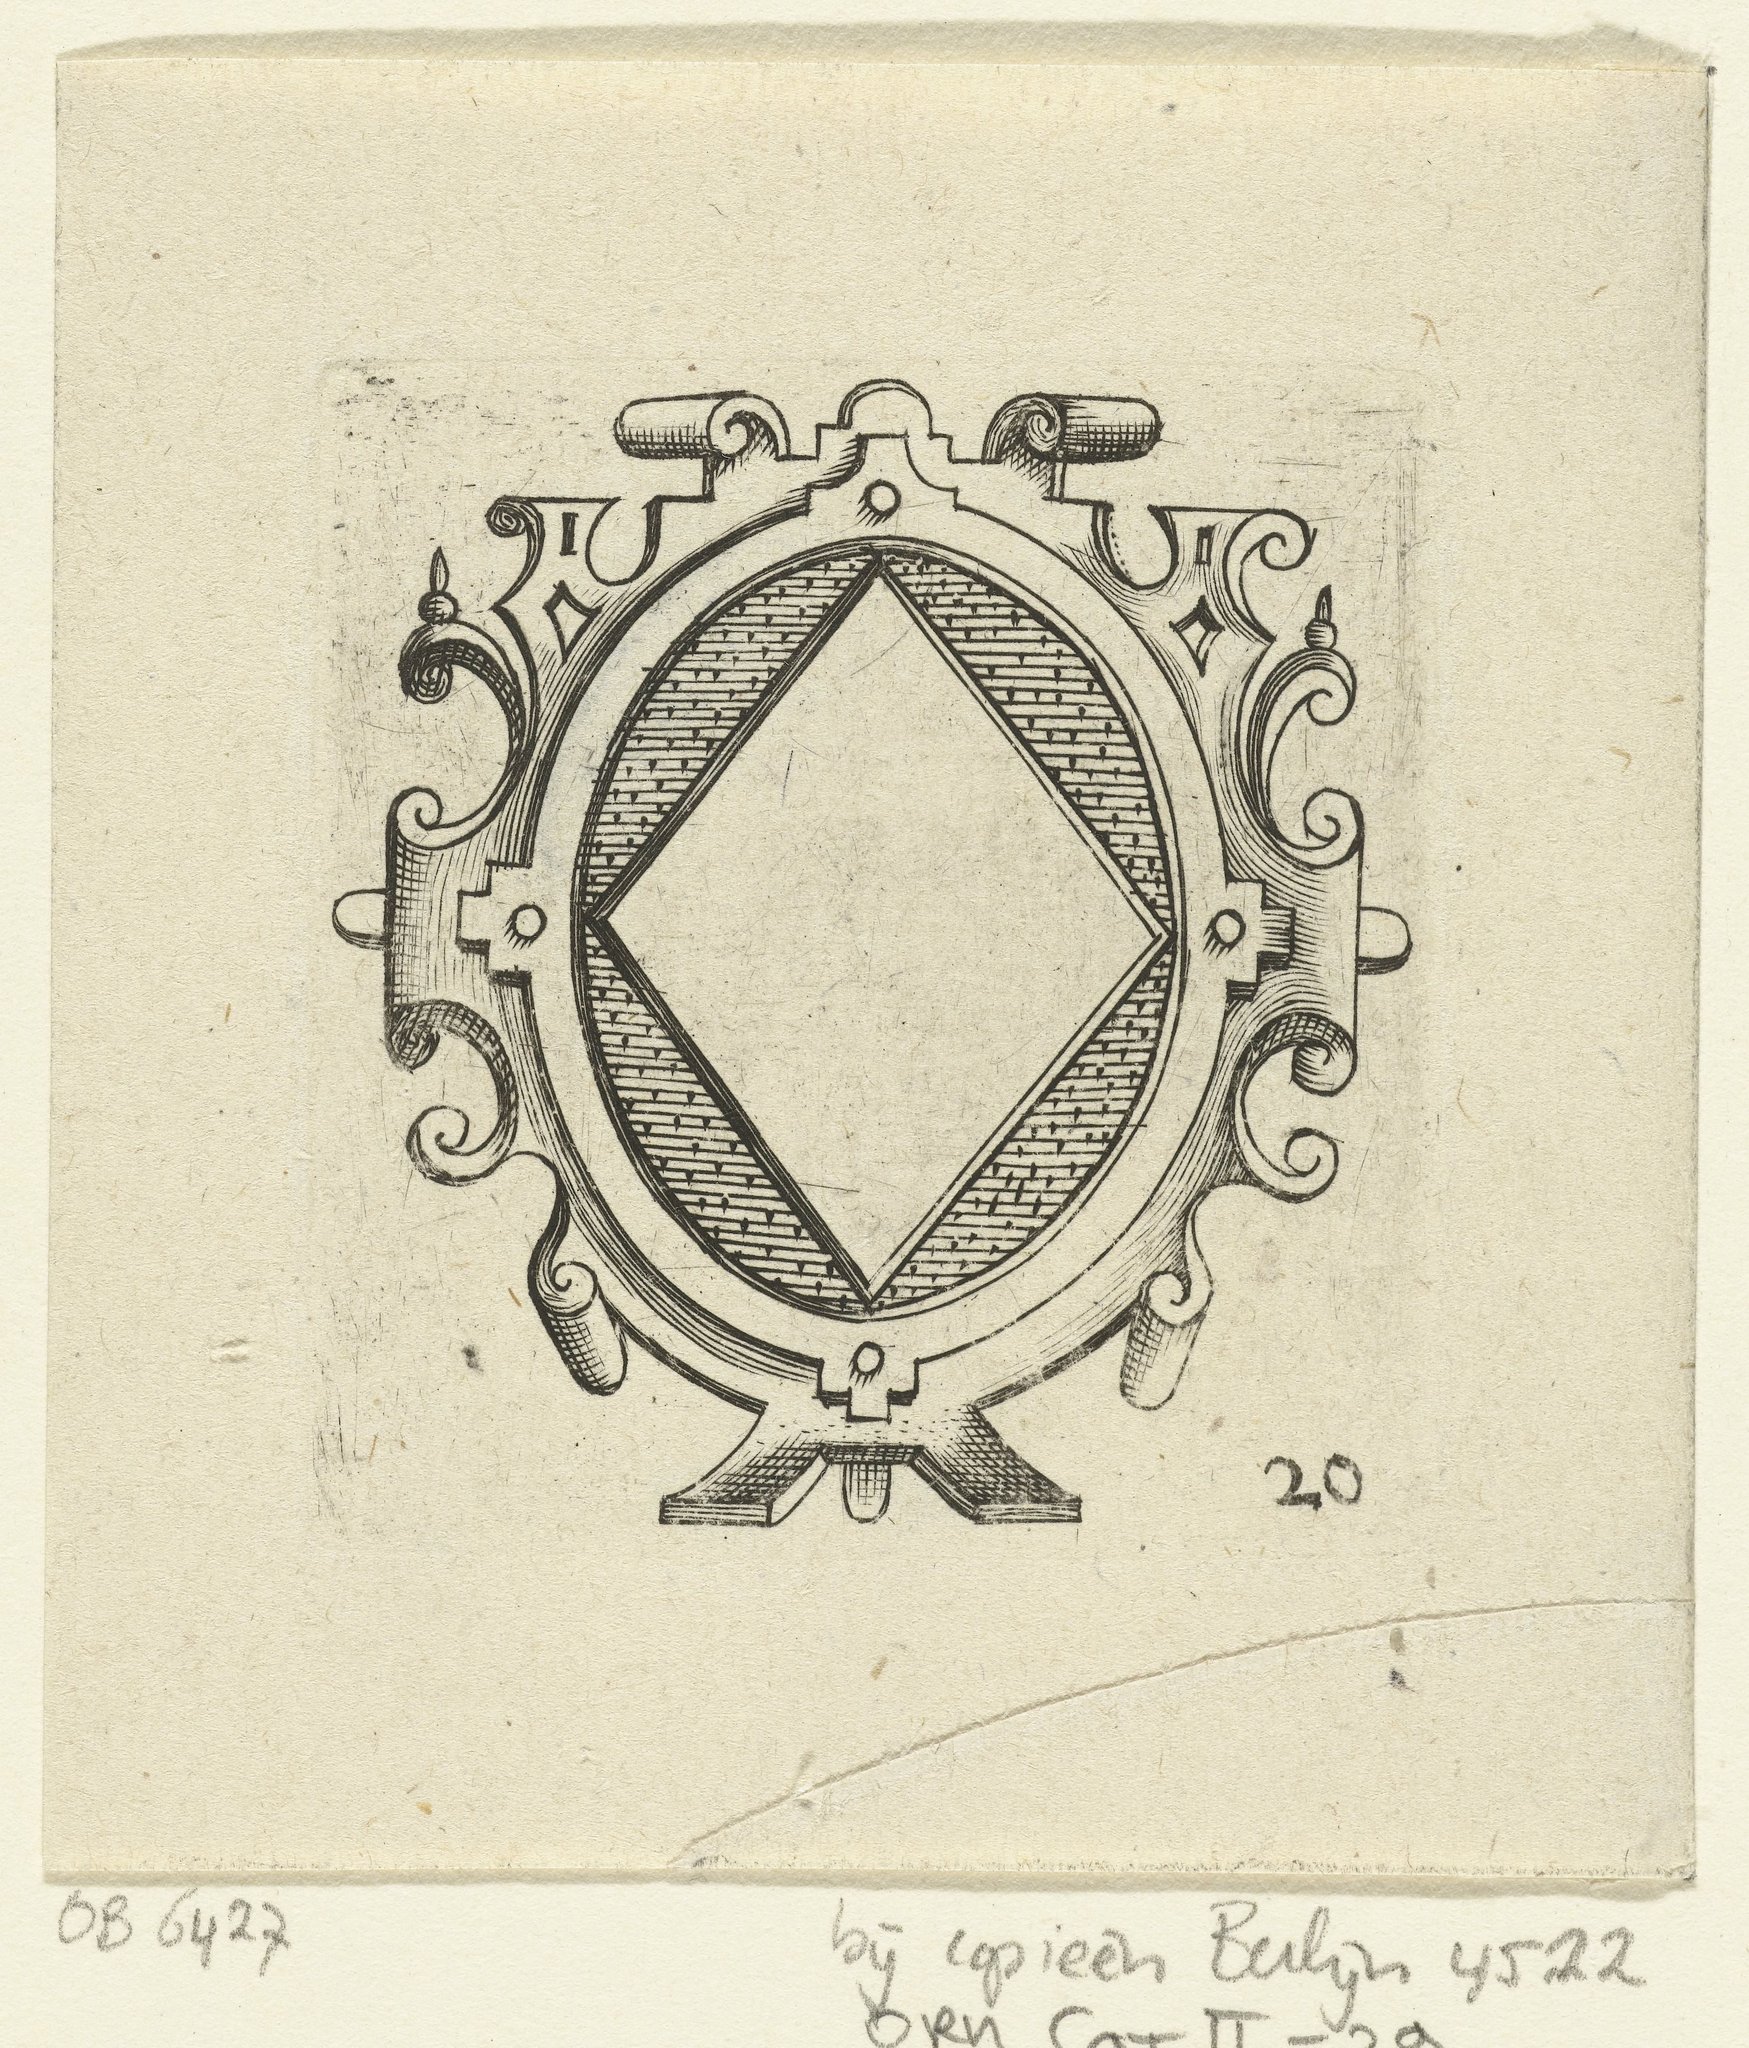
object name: ornament print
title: Wapenschild met ruitvormig veld in een ovaal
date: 1625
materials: paper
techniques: engraving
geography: amsterdam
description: De rand bestaat uit rolwerk. Blad uit serie wapenschilden met lege compartimenten.